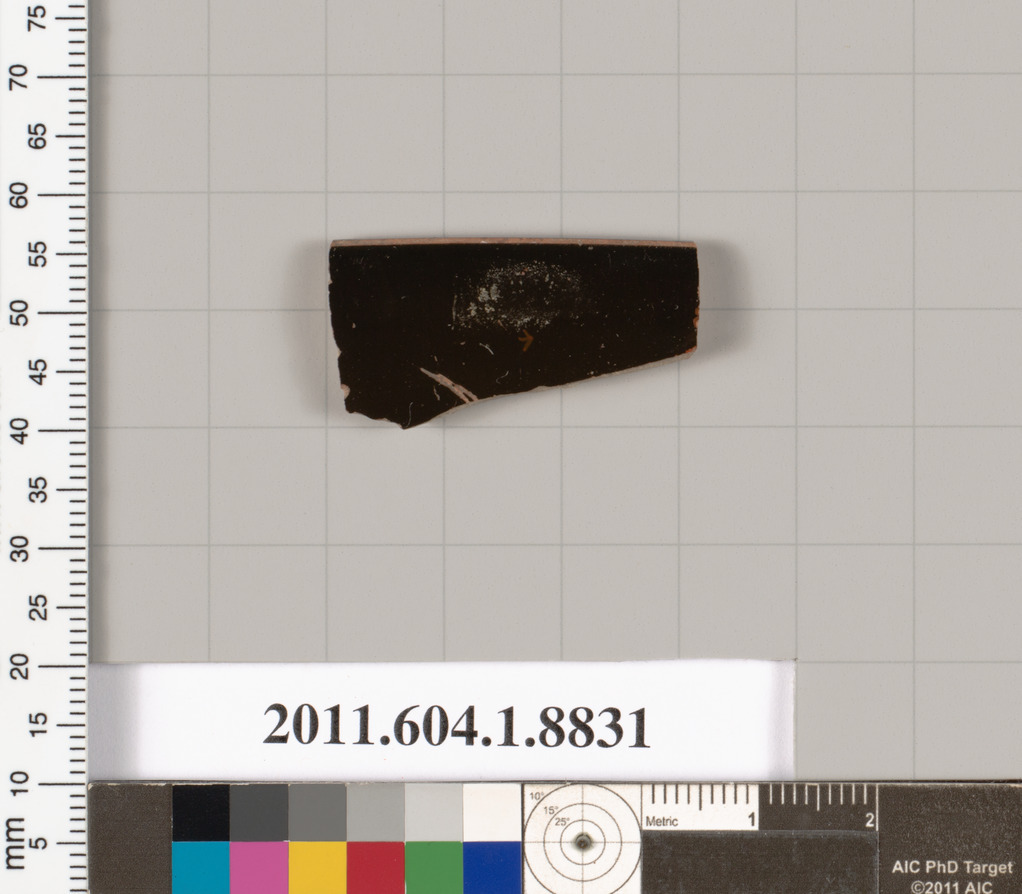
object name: kylix fragment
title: Terracotta rim fragment of a kylix (drinking cup)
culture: greek, attic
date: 500-470 BCE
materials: terracotta